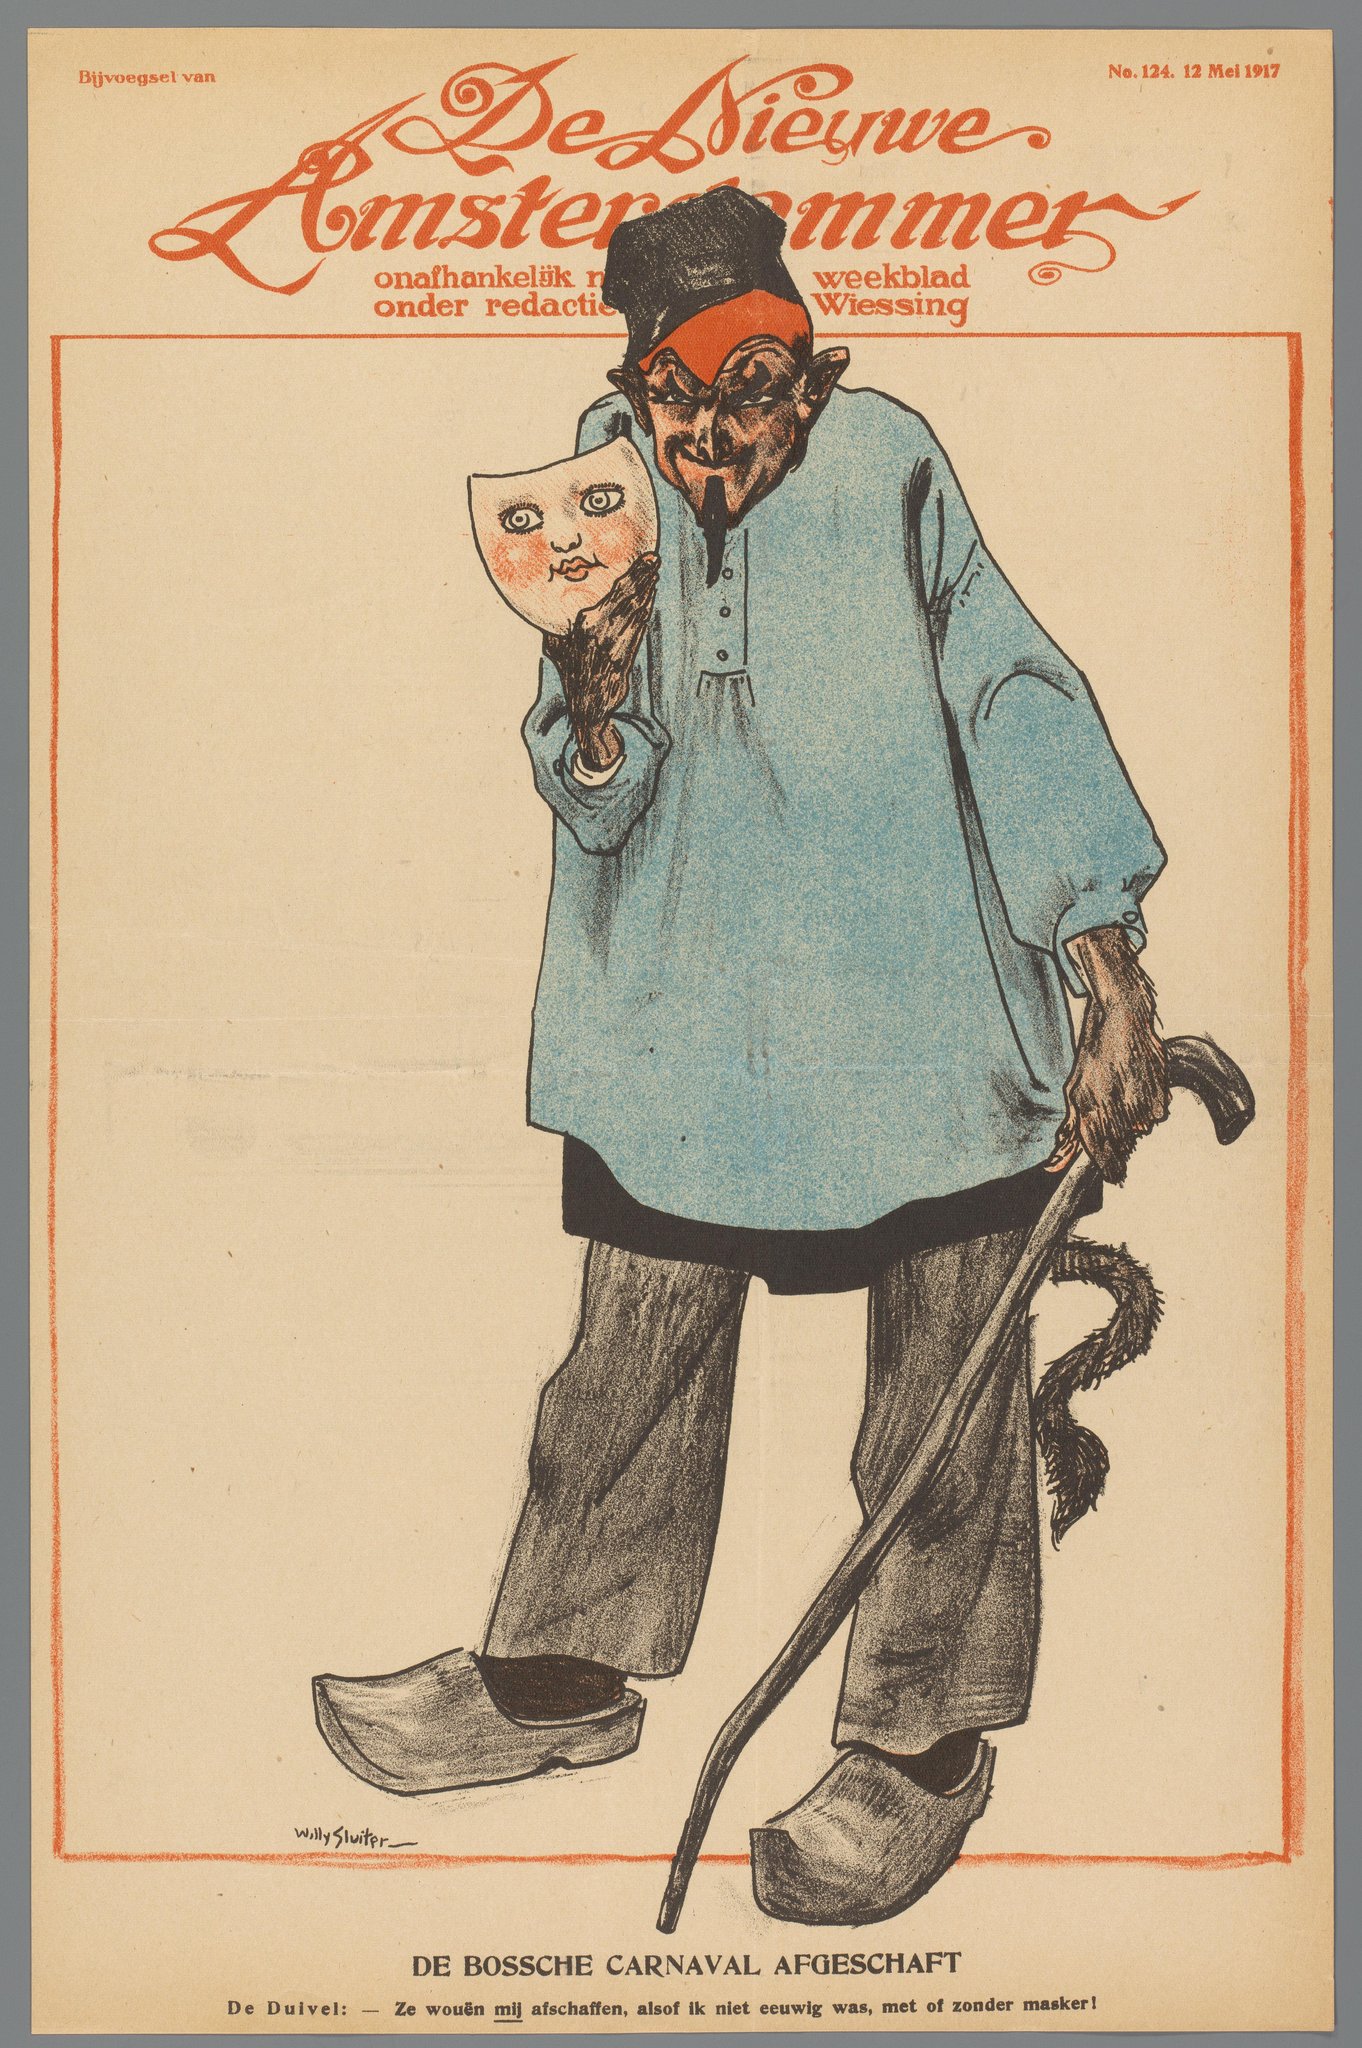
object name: print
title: De Bossche carnaval afgeschaft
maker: willy sluiter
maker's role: draughtsman, painter, print maker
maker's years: 1873-1949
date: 1917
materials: paper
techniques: lithograph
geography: netherlands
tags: mask, carnival, shrovetide (non-liturgical celebration), human-shaped devil, political caricatures and satires, den bosch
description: Deze prent werd uitgegeven als Bijvoegsel van De Nieuwe Amsterdammer. Onafhankelijk Nederlandsch weekblad onder redactie van Mr. H.P.L. Wiessing, Amsterdam, nr. 124, 12 mei 1917.